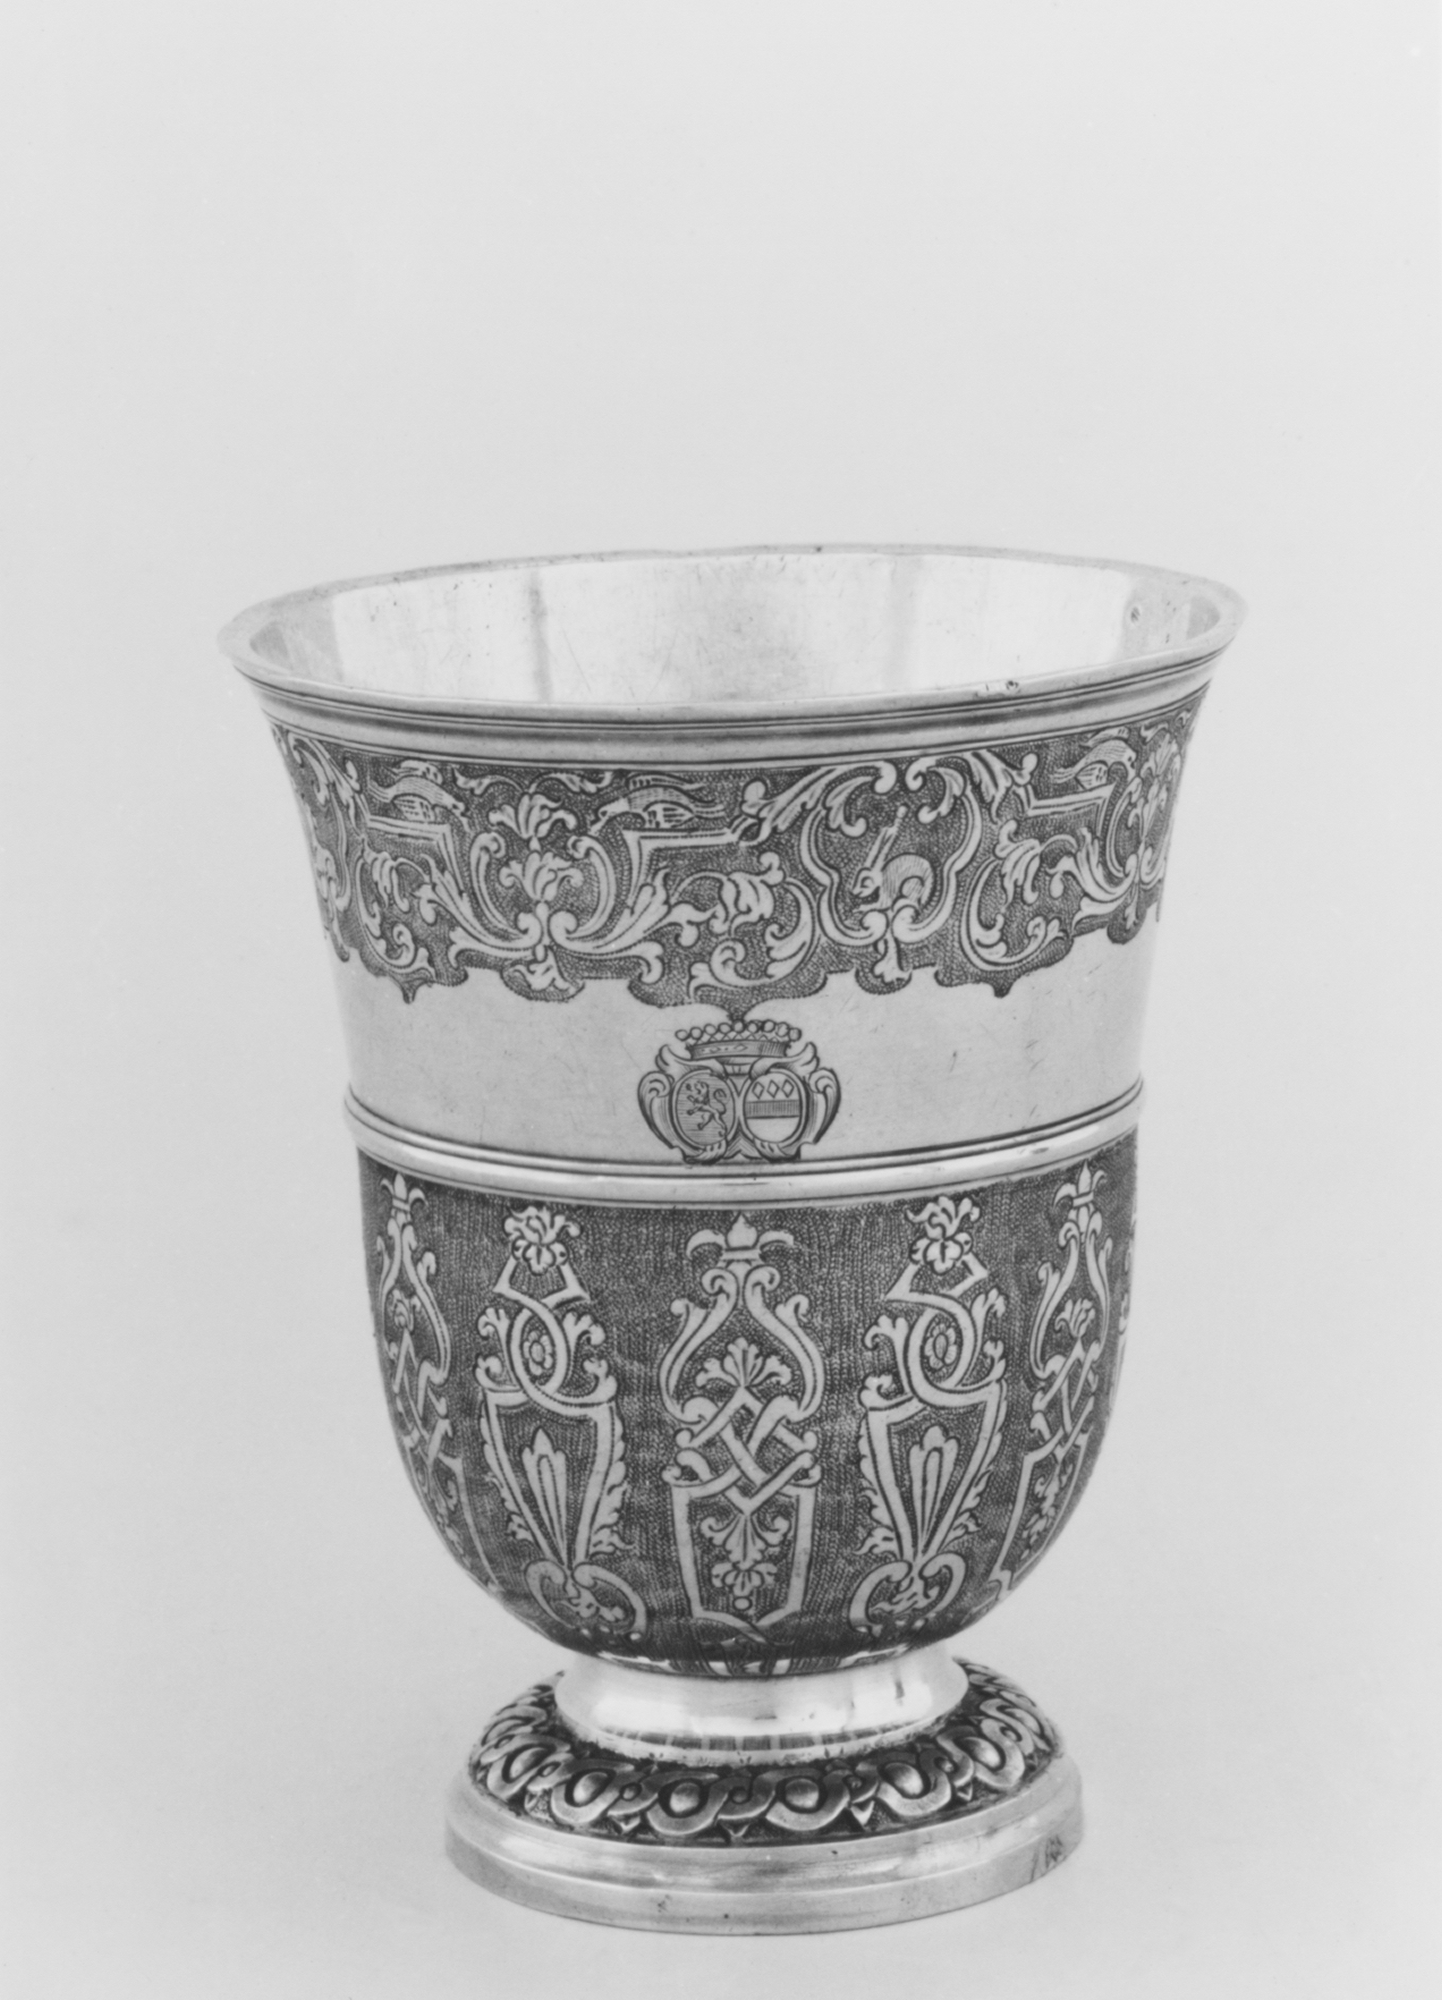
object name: beaker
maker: gabriel-joseph moillet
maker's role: maker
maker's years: 1681-1757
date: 1721-1722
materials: silver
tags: coat of arms